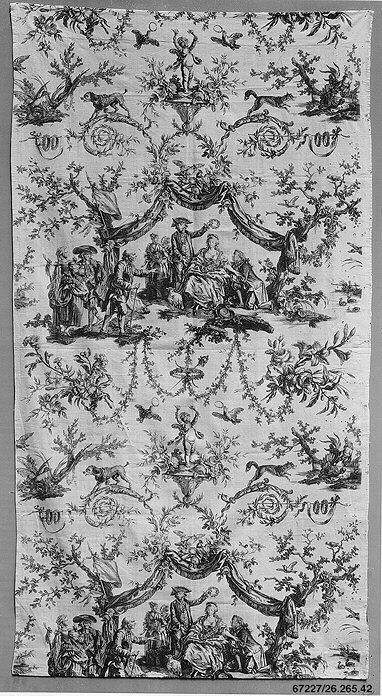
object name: furnishing textile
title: "Le Couronnement de la Rosière"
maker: jean-baptiste huet i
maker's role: designer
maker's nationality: french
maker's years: 1745-1811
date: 1785-1790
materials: linen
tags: birds,men,women,dogs,foxes,sheep,flowers